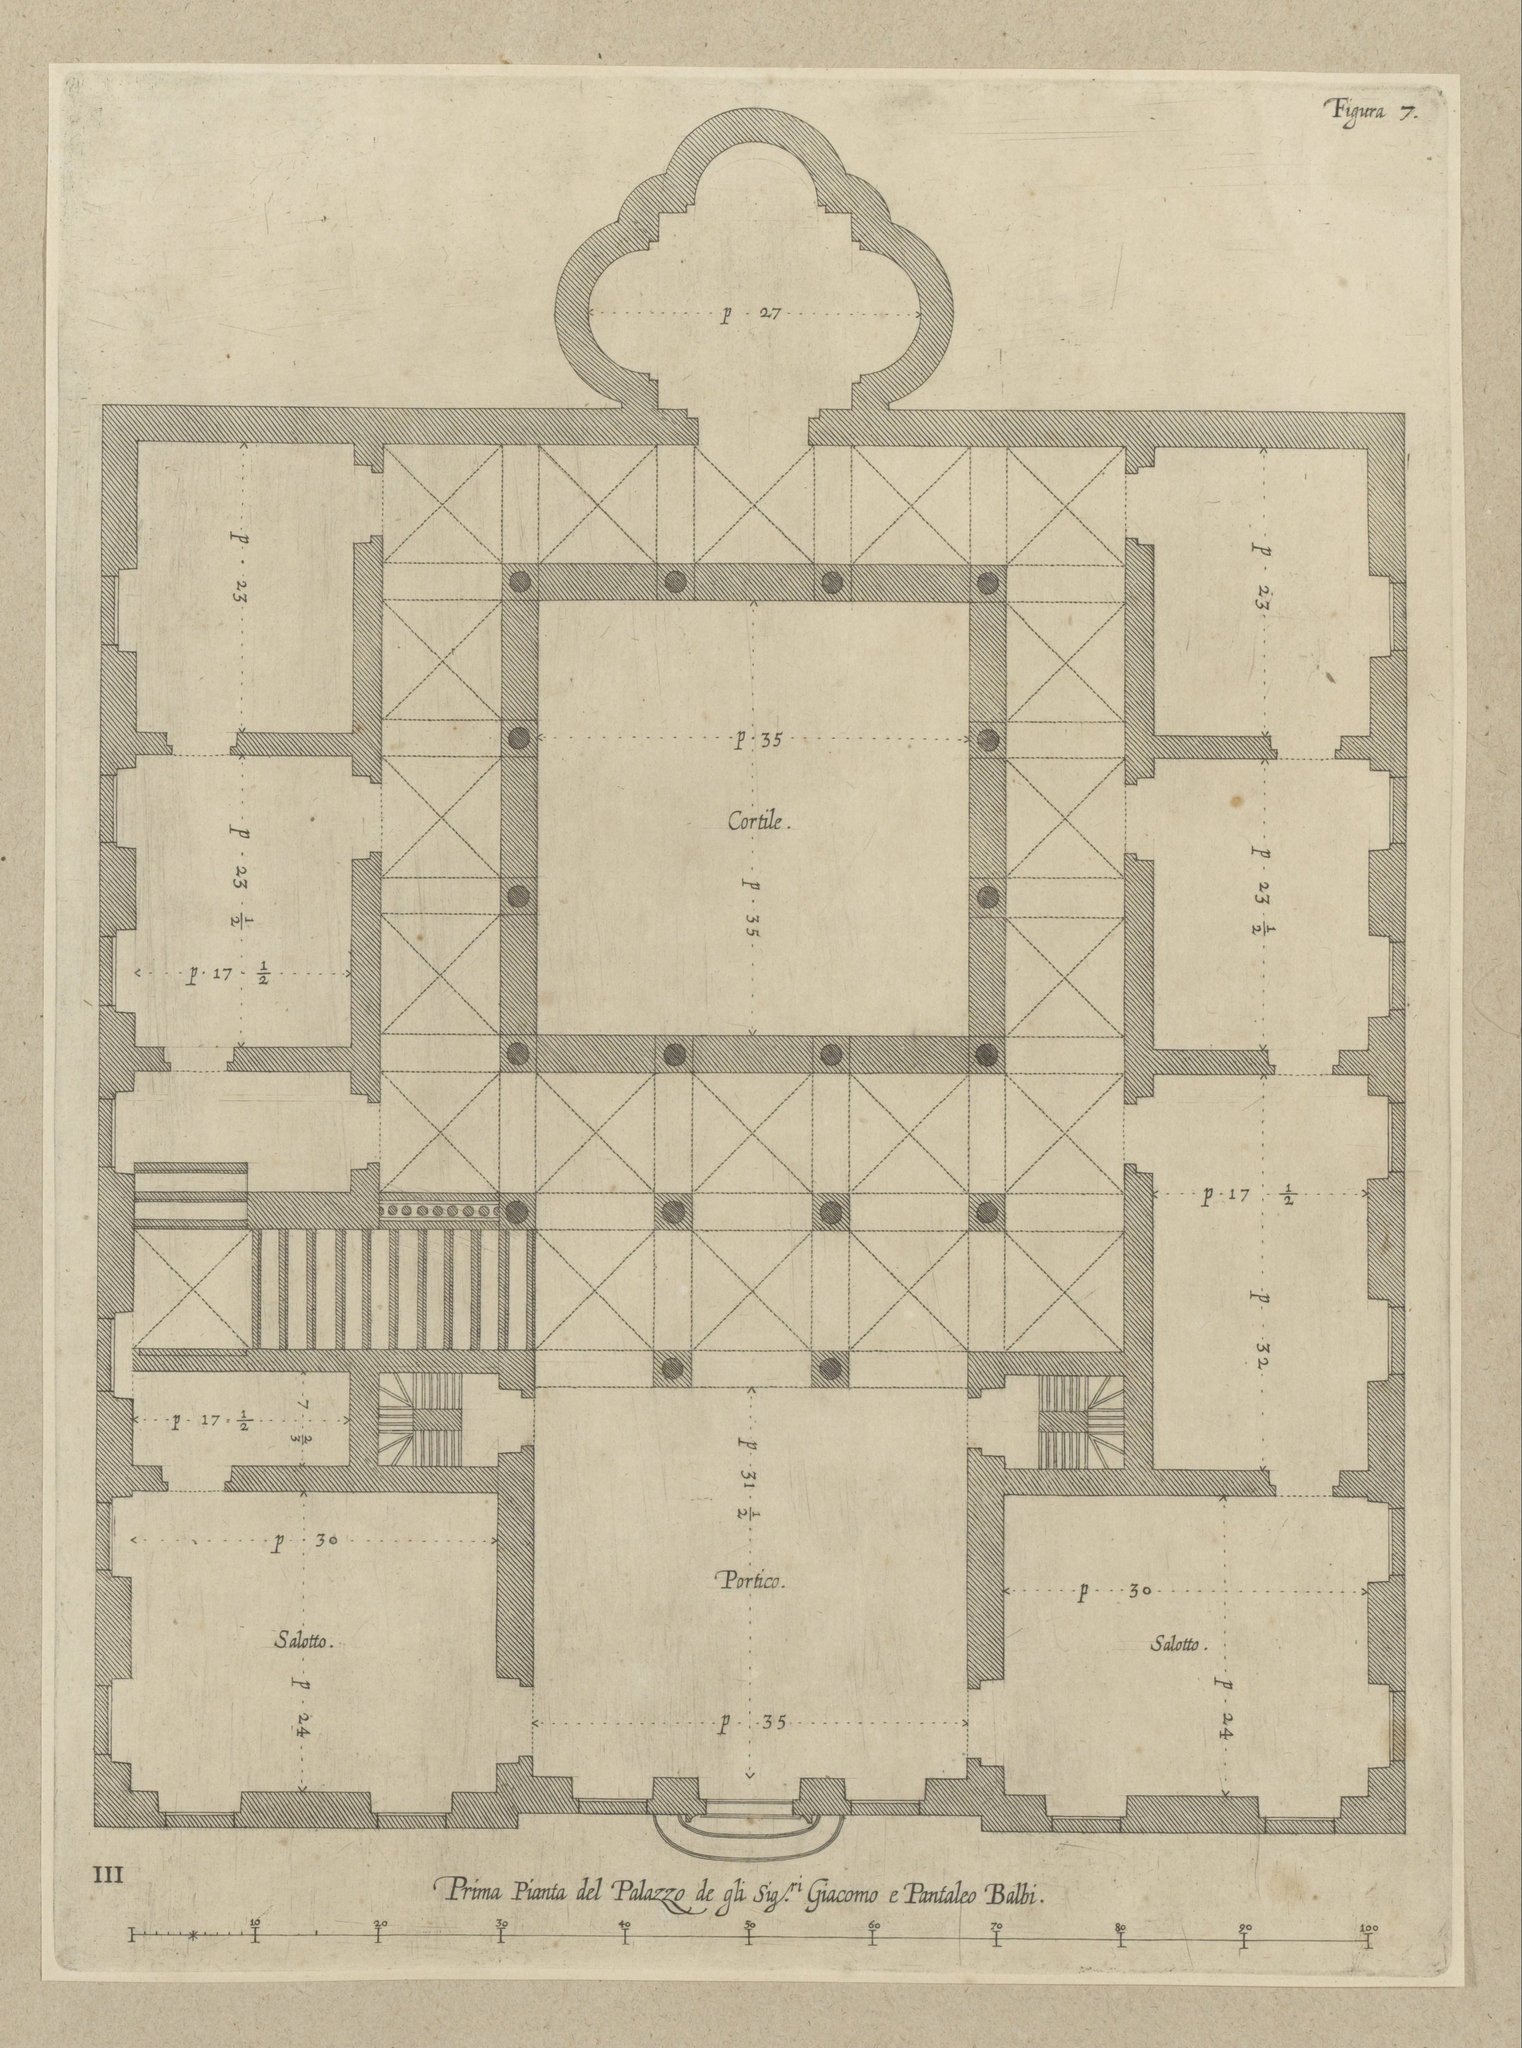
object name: album leaf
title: Seconda pianta del Palazzo de sig.ri Giacomo e Pantaleo Balbi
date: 1622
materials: paper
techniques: engraving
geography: antwerp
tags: hôtel, i.e. small palace in city - aa - civic architecture: inside, plan ~ architecture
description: Deze prent maakt deel uit van een album.